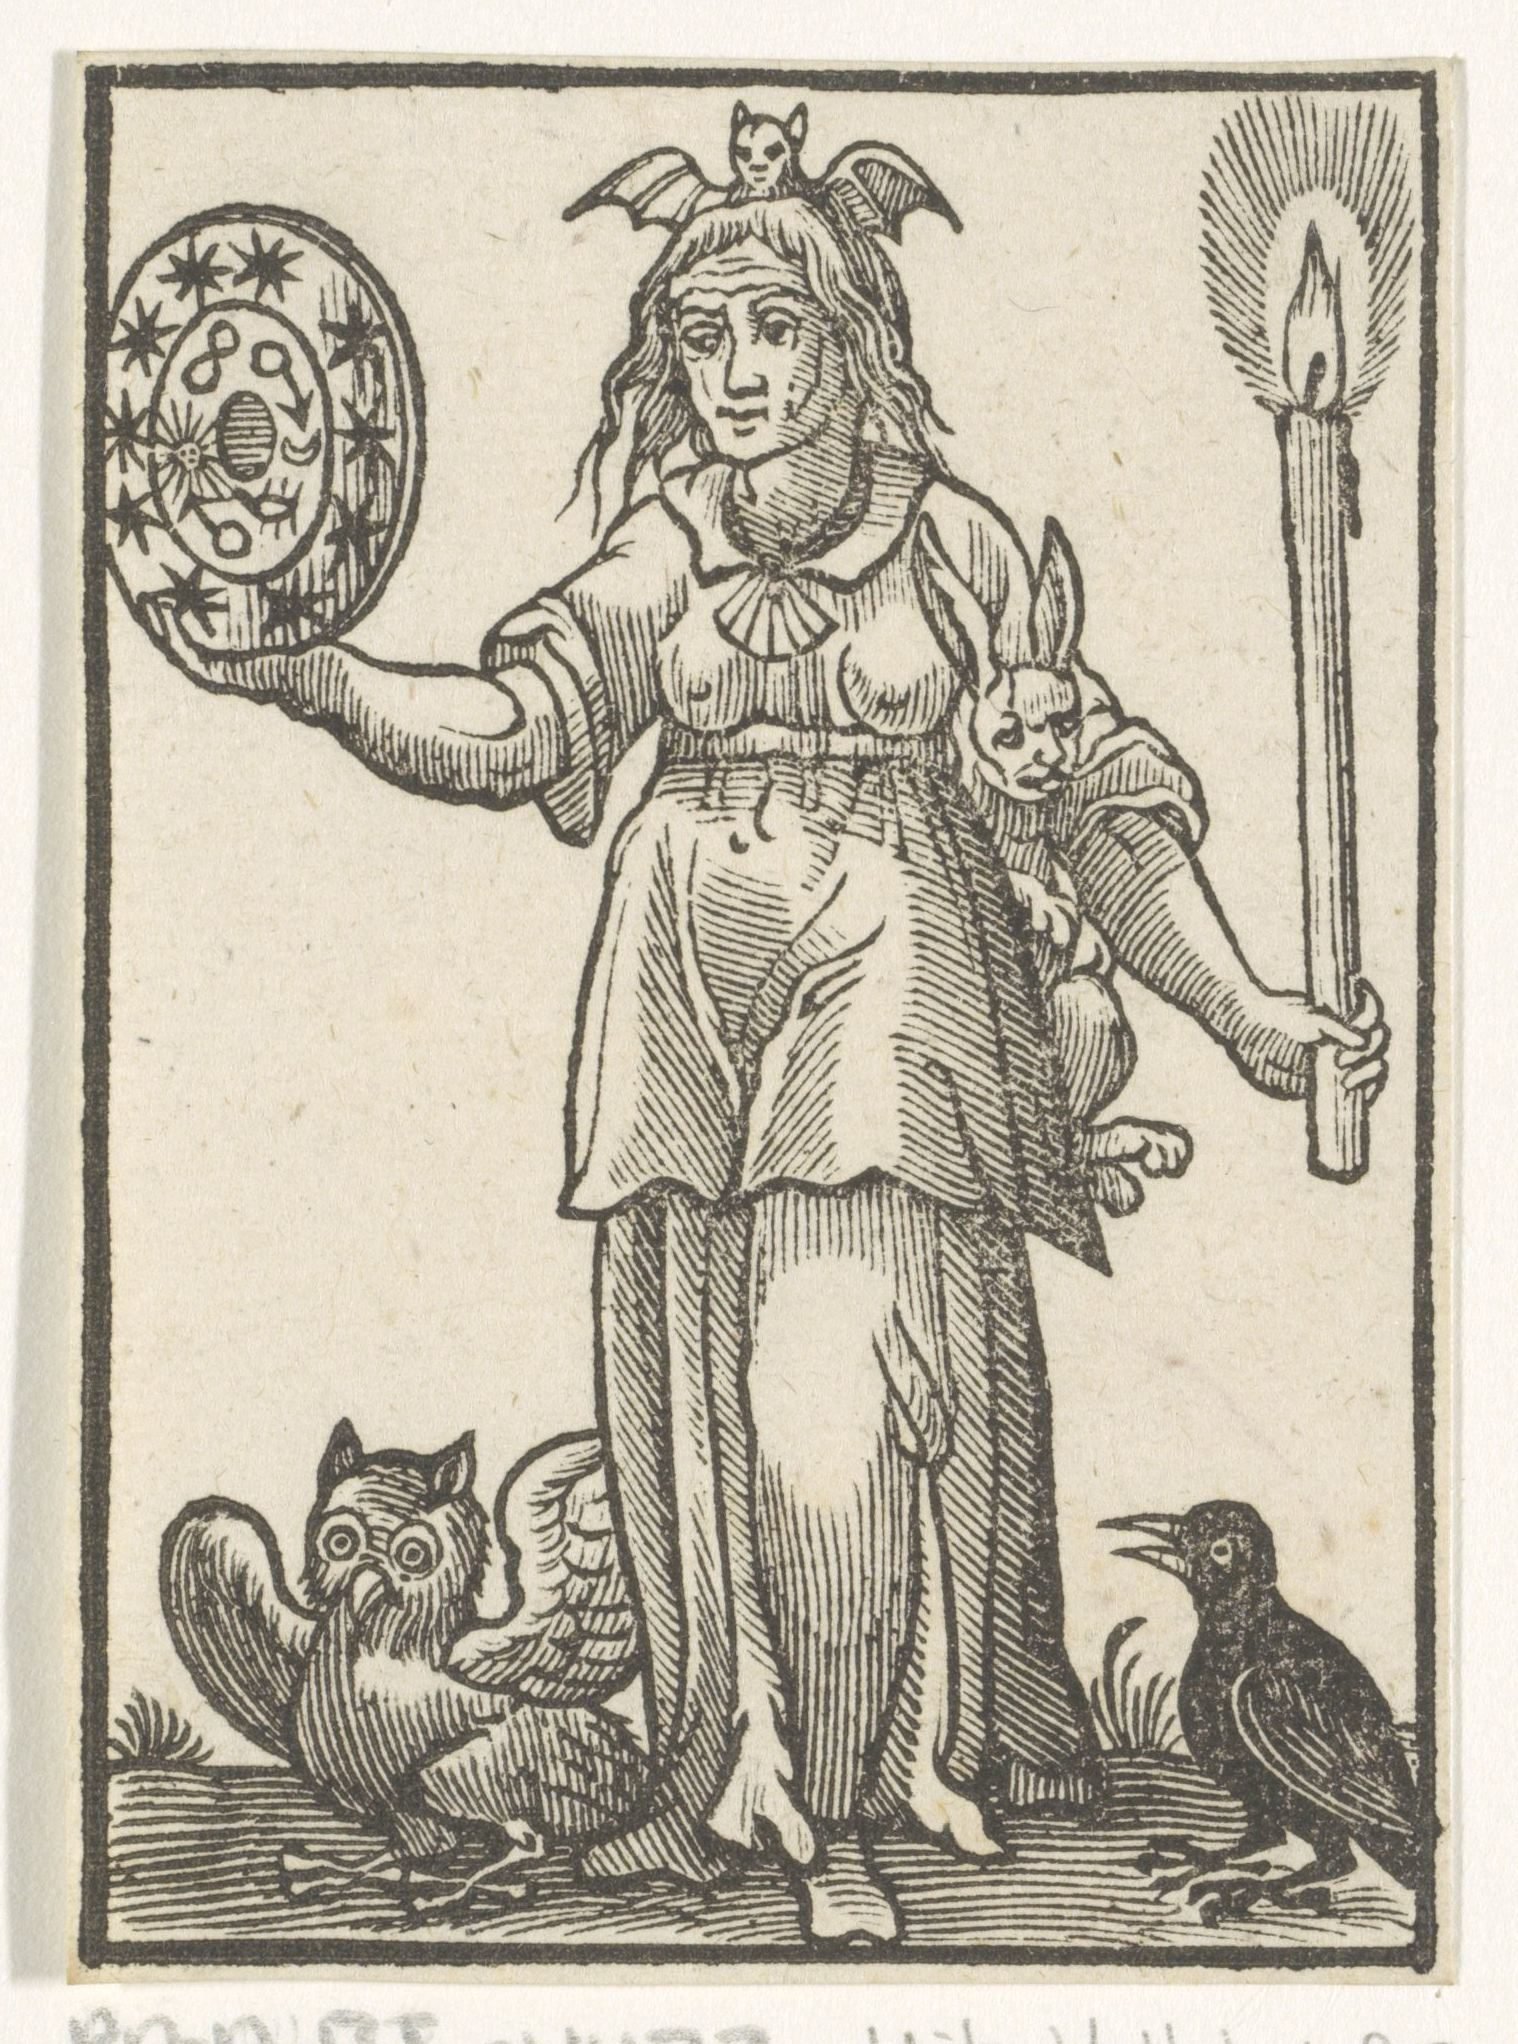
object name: print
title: Superstitie of Bijgelovigheid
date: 1644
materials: paper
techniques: woodcut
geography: antwerp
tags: 'superstitione' (ripa)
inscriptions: collector's mark: Lugt 240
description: Een oude vrouw heeft in haar rechterhand een cirkel van sterren en tekens van de dierenriem en in haar linkerhand een lange kaars. Naast haar zitten een nachtuil en een kraai. Op haar hoofd zit een vleermuis en onder haar arm een haas.